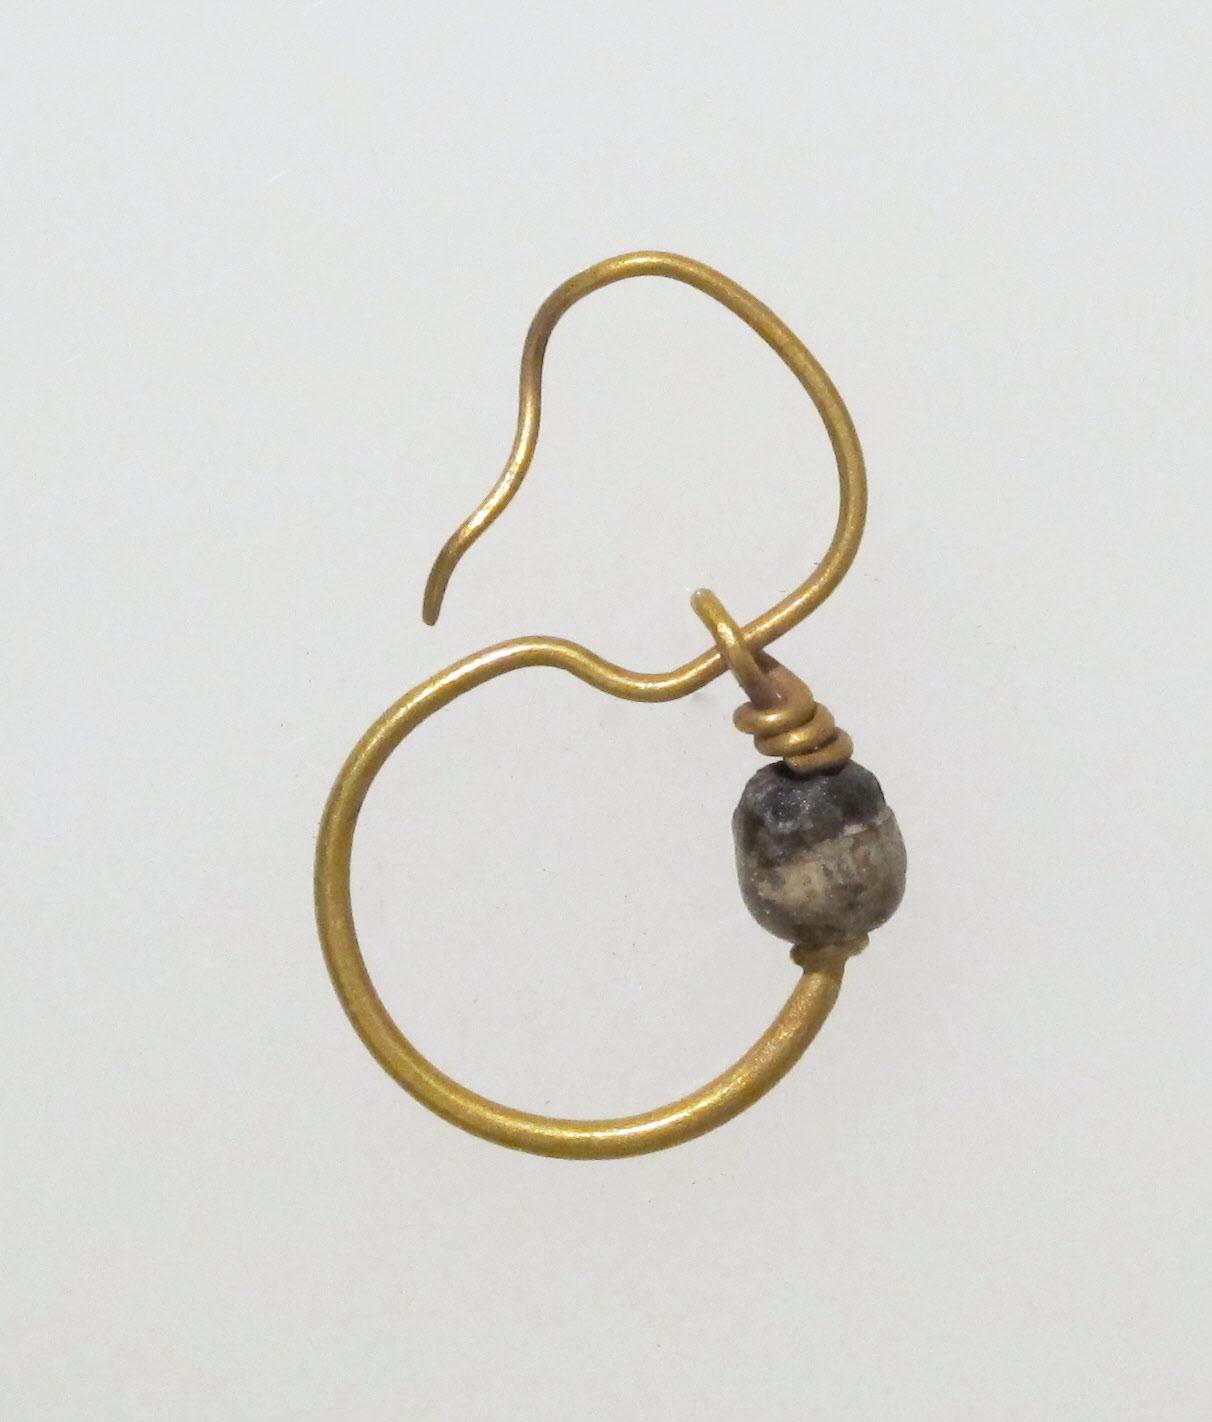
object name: earring, delta shaped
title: Earring, delta-shaped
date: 7000 BCE-330 CE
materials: gold